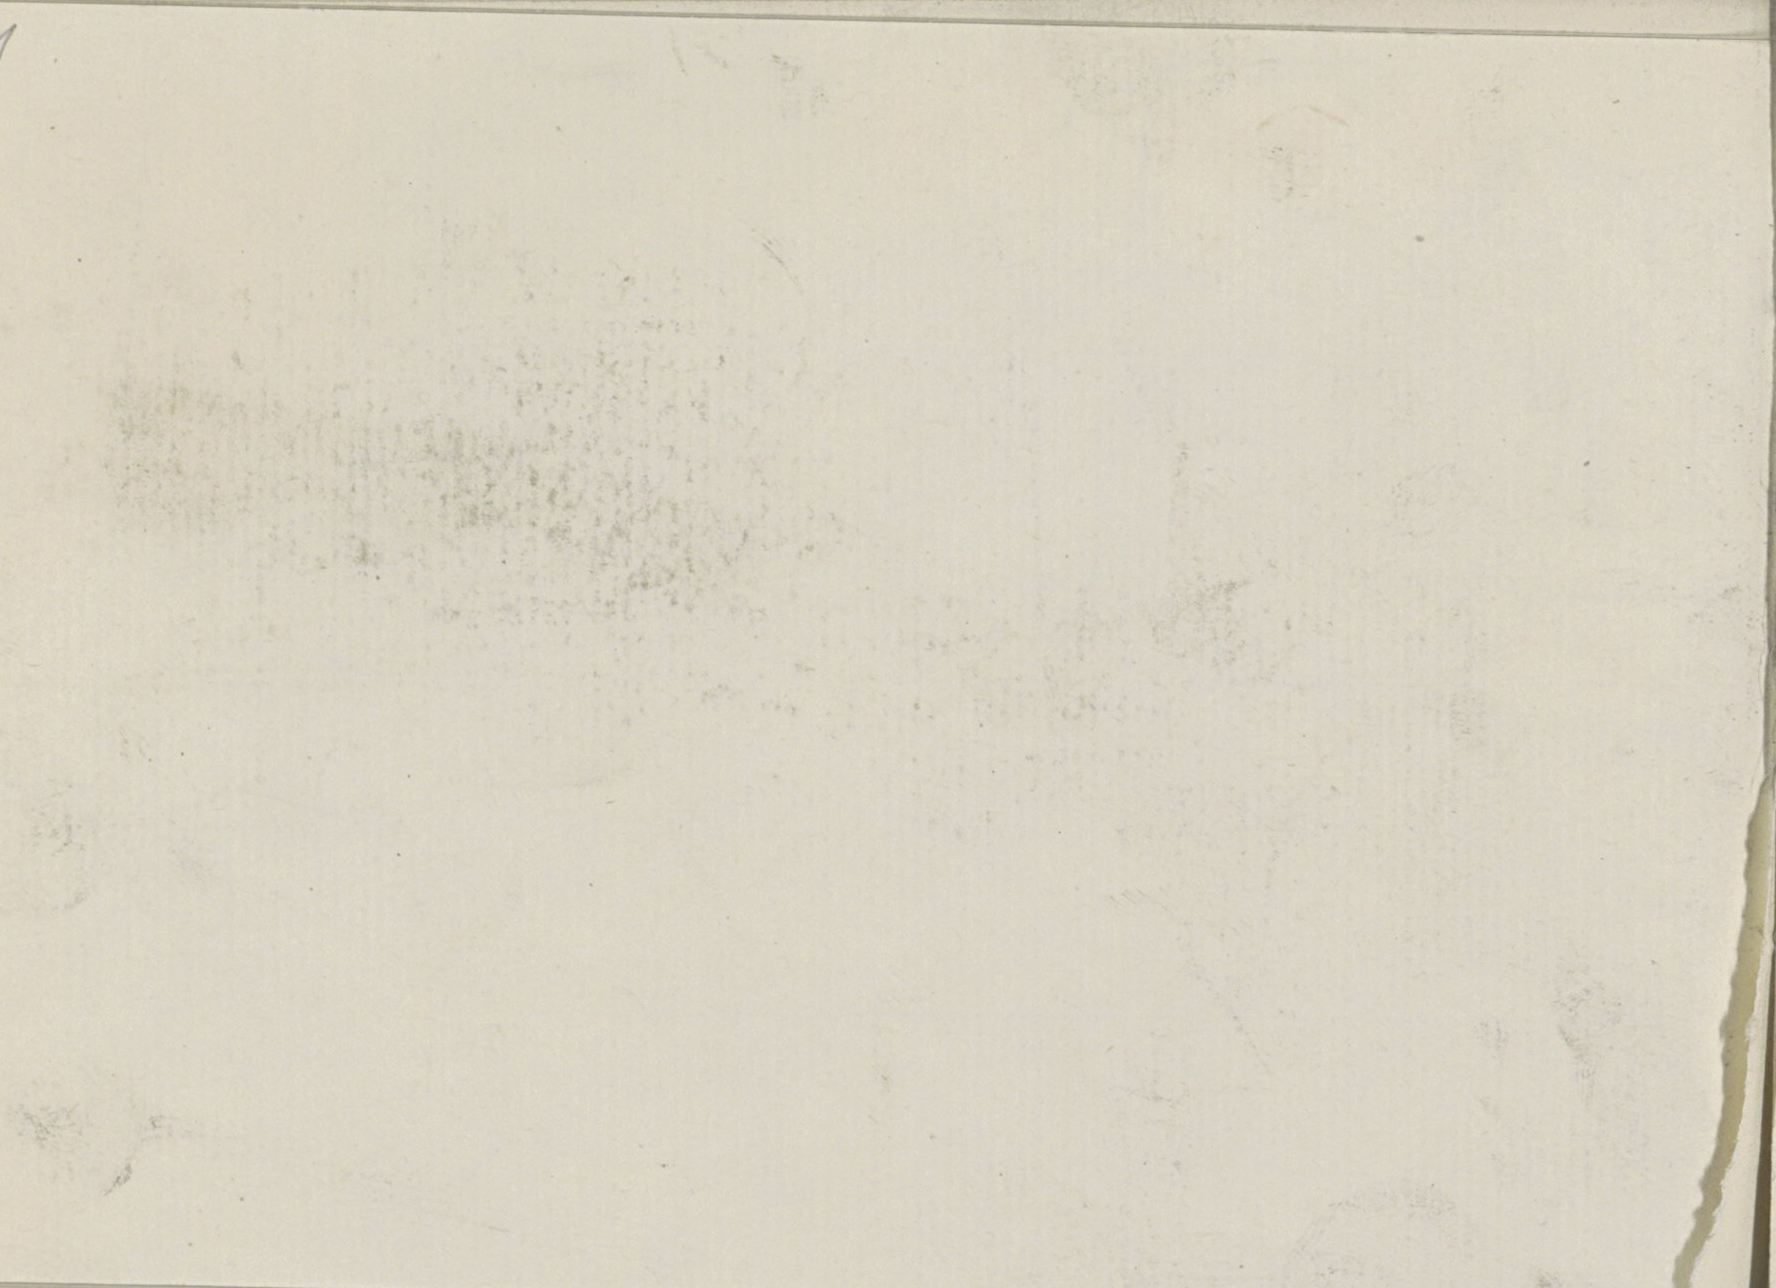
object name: sketchbook leaf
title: Abklatsch van de krijttekening op blad 3 recto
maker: isaac israels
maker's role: draughtsman, painter, print maker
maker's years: 1865-1934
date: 1875-1934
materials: paper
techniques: printmaking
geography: amsterdam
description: Blad 2 verso uit schetsboek XXXI met 10 bladen.